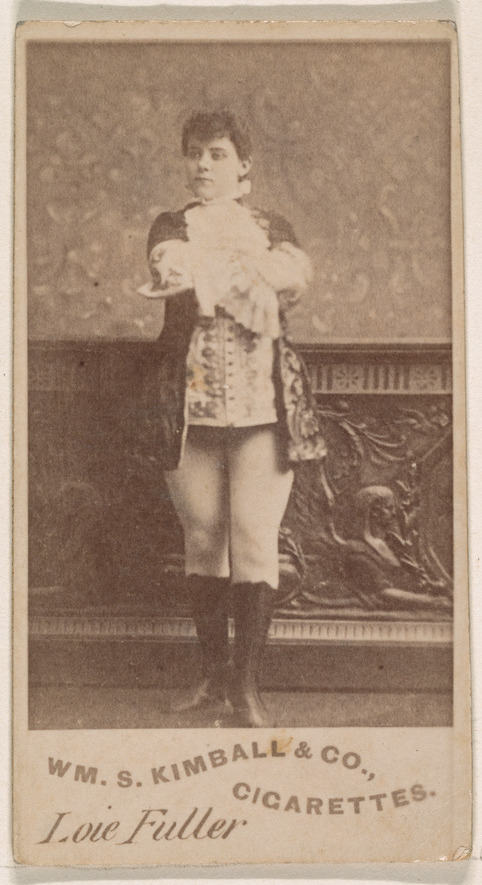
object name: photograph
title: Loie Fuller, from the Actresses series (N203) issued by Wm. S. Kimball & Co.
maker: william s. kimball & company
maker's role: publisher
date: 1889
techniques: color lithograph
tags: portraits,women,actresses